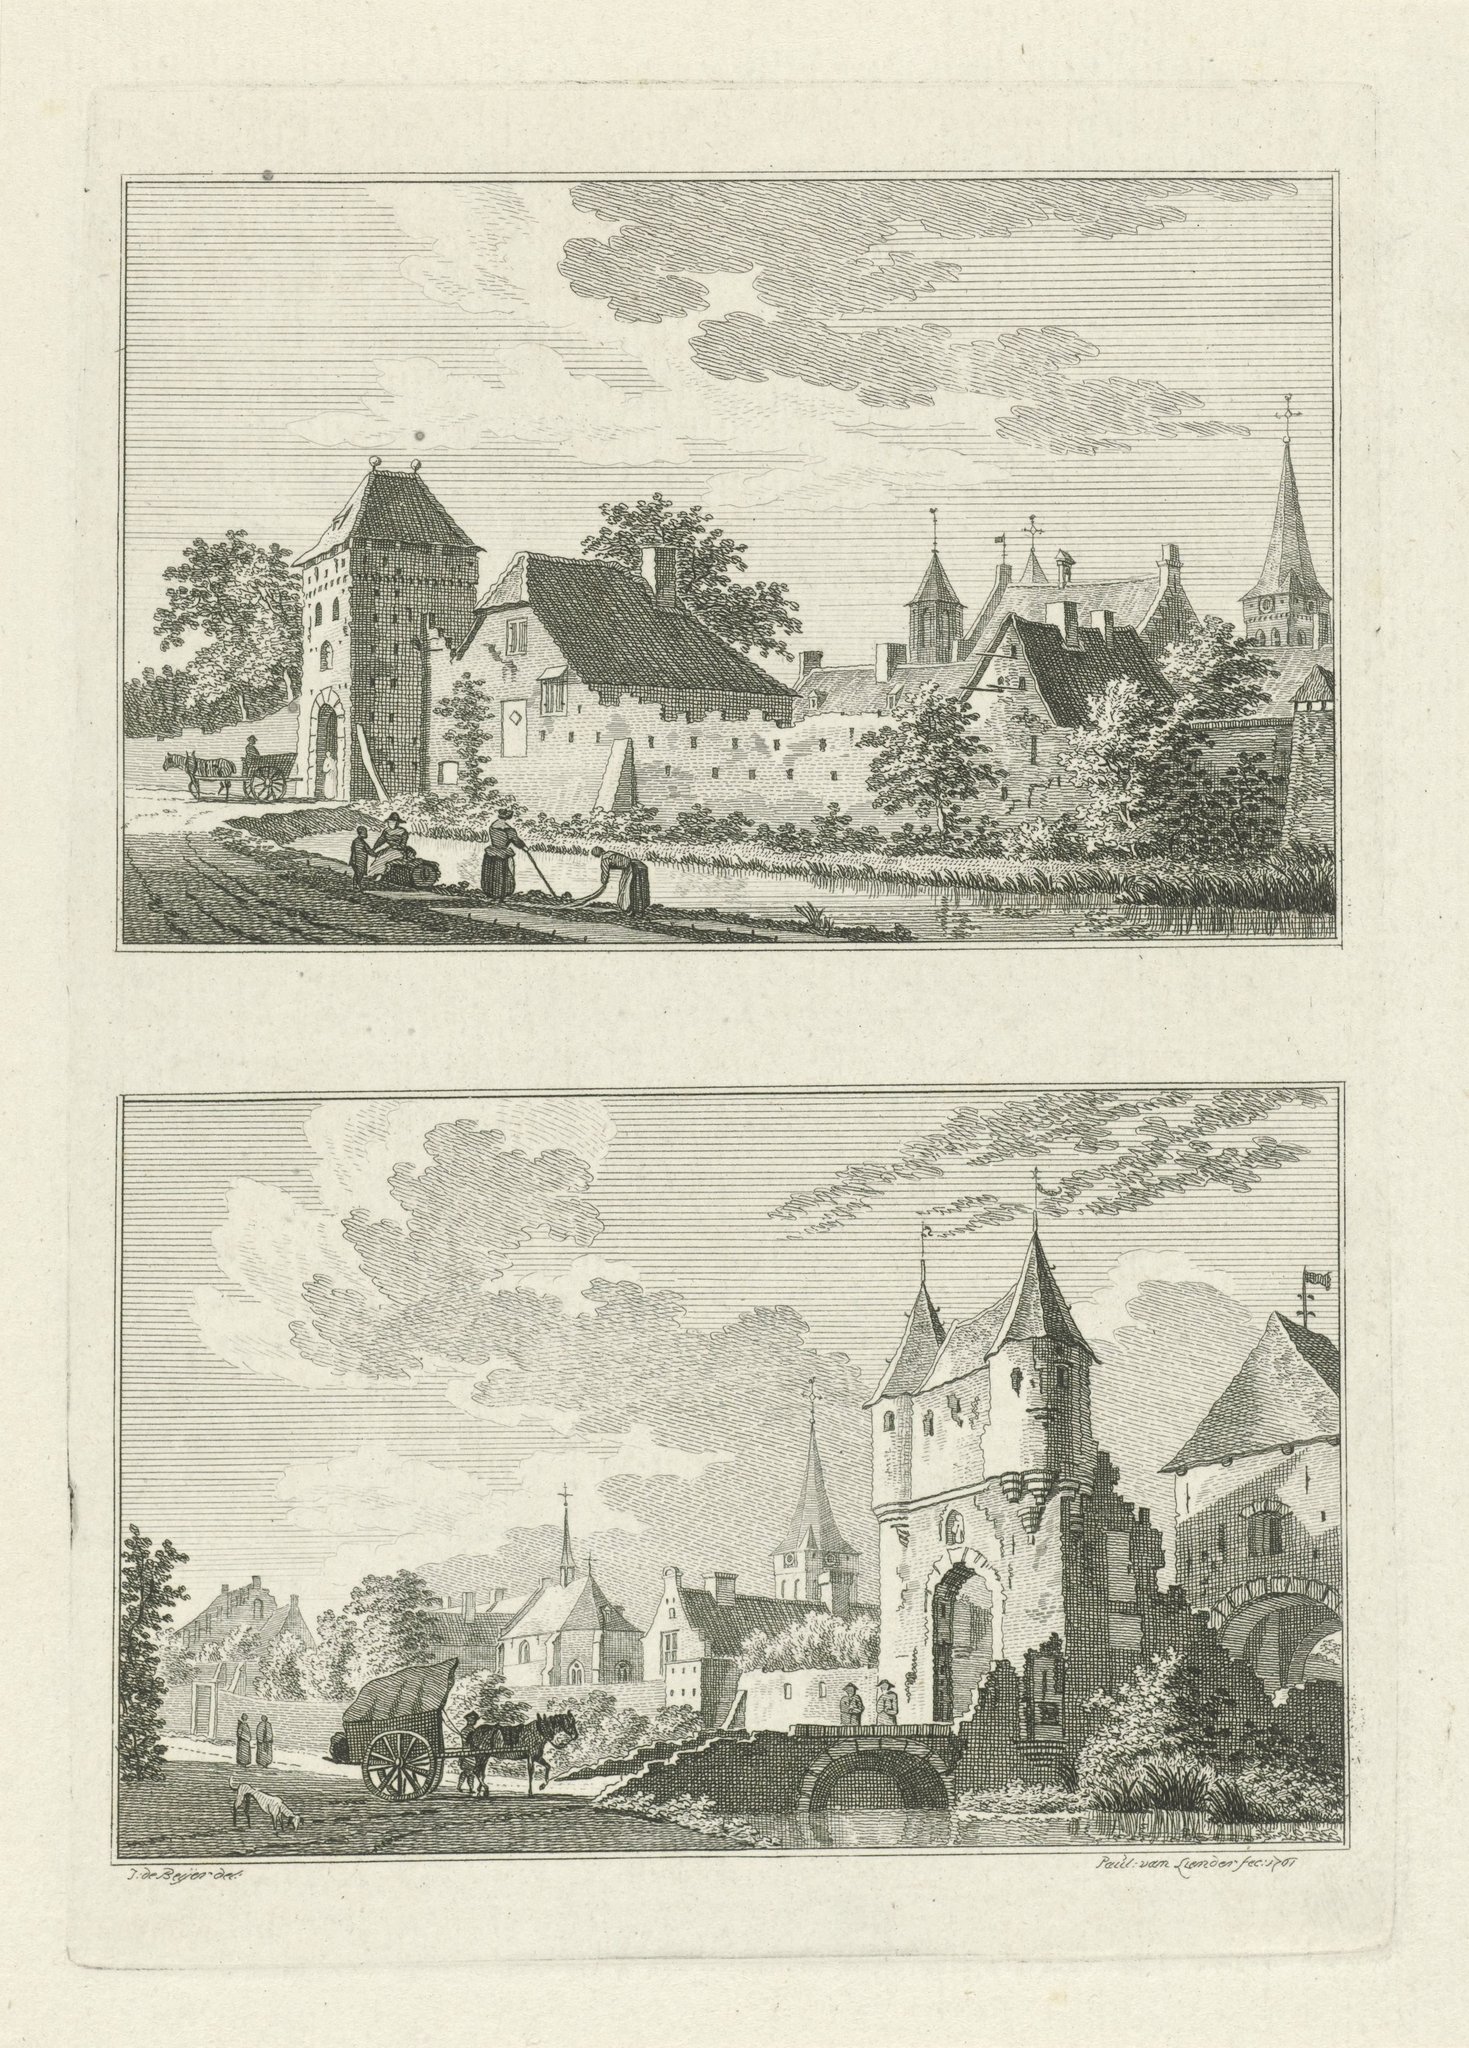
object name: print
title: Veepoort en Loopoort te Uedem, 1744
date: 1761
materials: paper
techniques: etching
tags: city-gate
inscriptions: collector's mark: Lugt 2228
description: Twee voorstellingen van één plaat. Gezichten op de Veepoort (boven) en de Loopoort (onder) te Uedem, Duitsland. De prent maakt deel uit van een 100-delige serie met gezichten op dorpen en steden te Kleef.